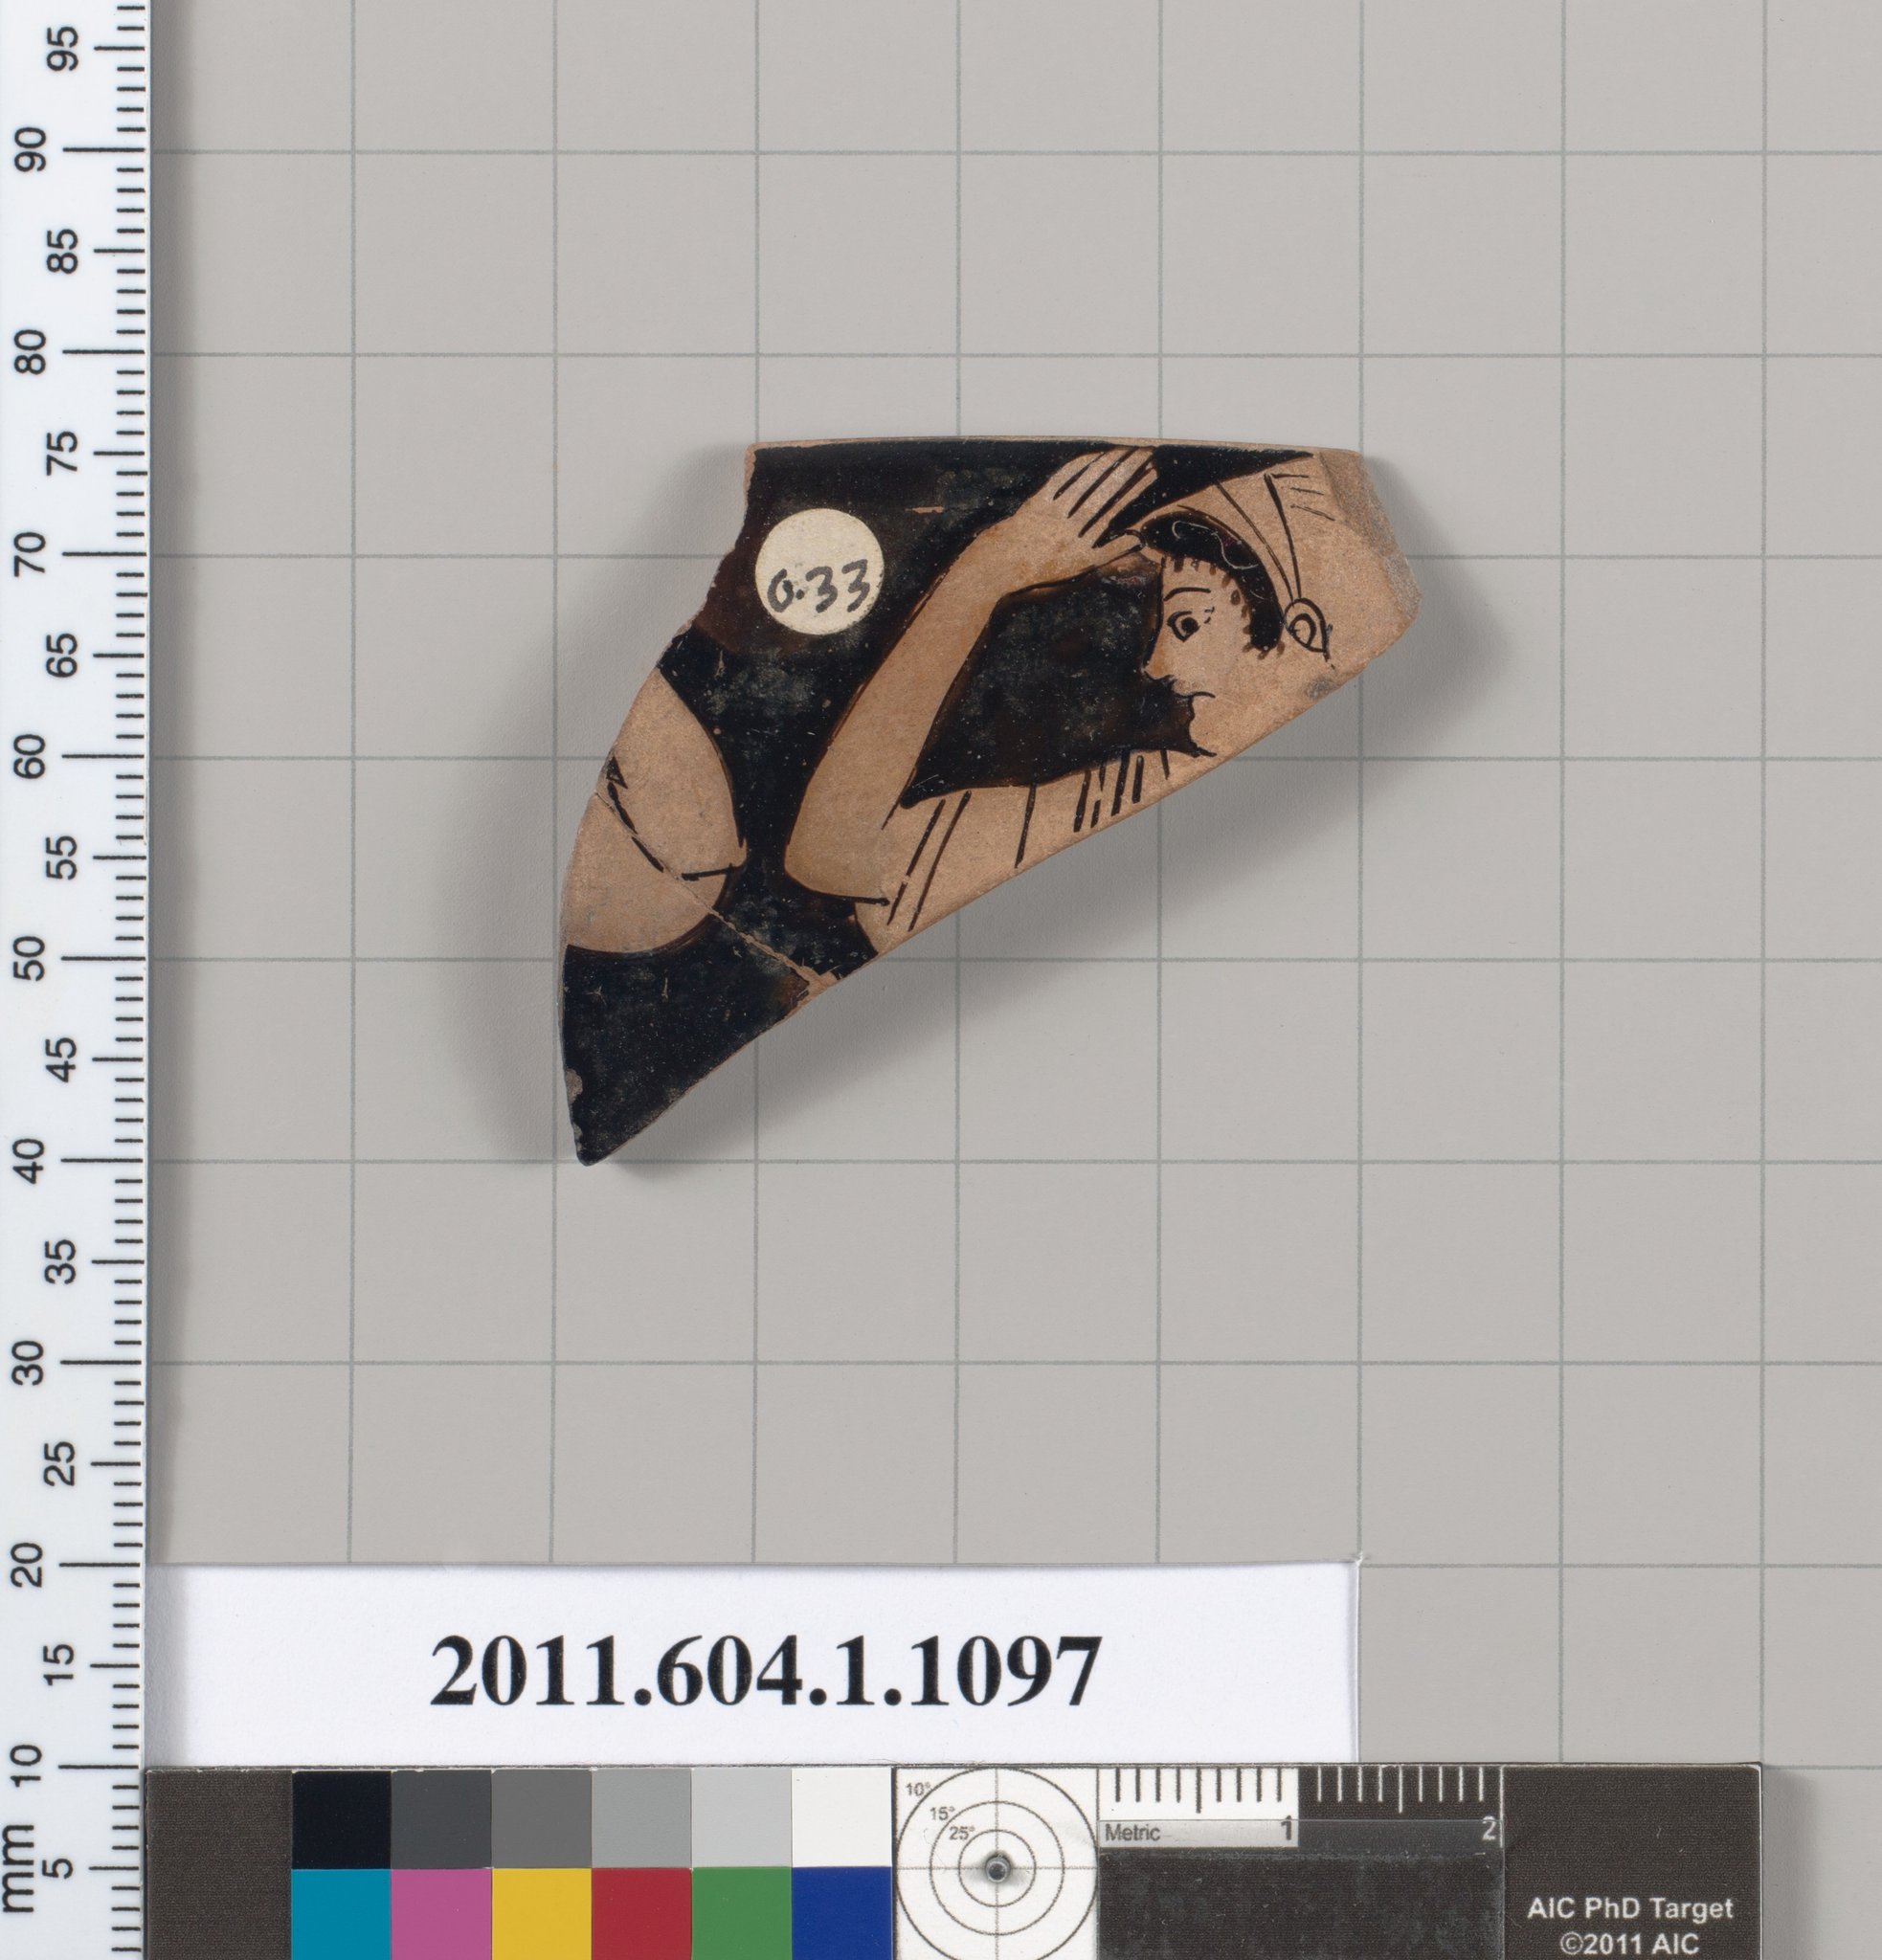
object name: kylix fragment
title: Terracotta rim fragment of a kylix (drinking cup)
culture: greek, attic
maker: nikosthenes painter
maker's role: artist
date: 520-500 BCE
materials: terracotta